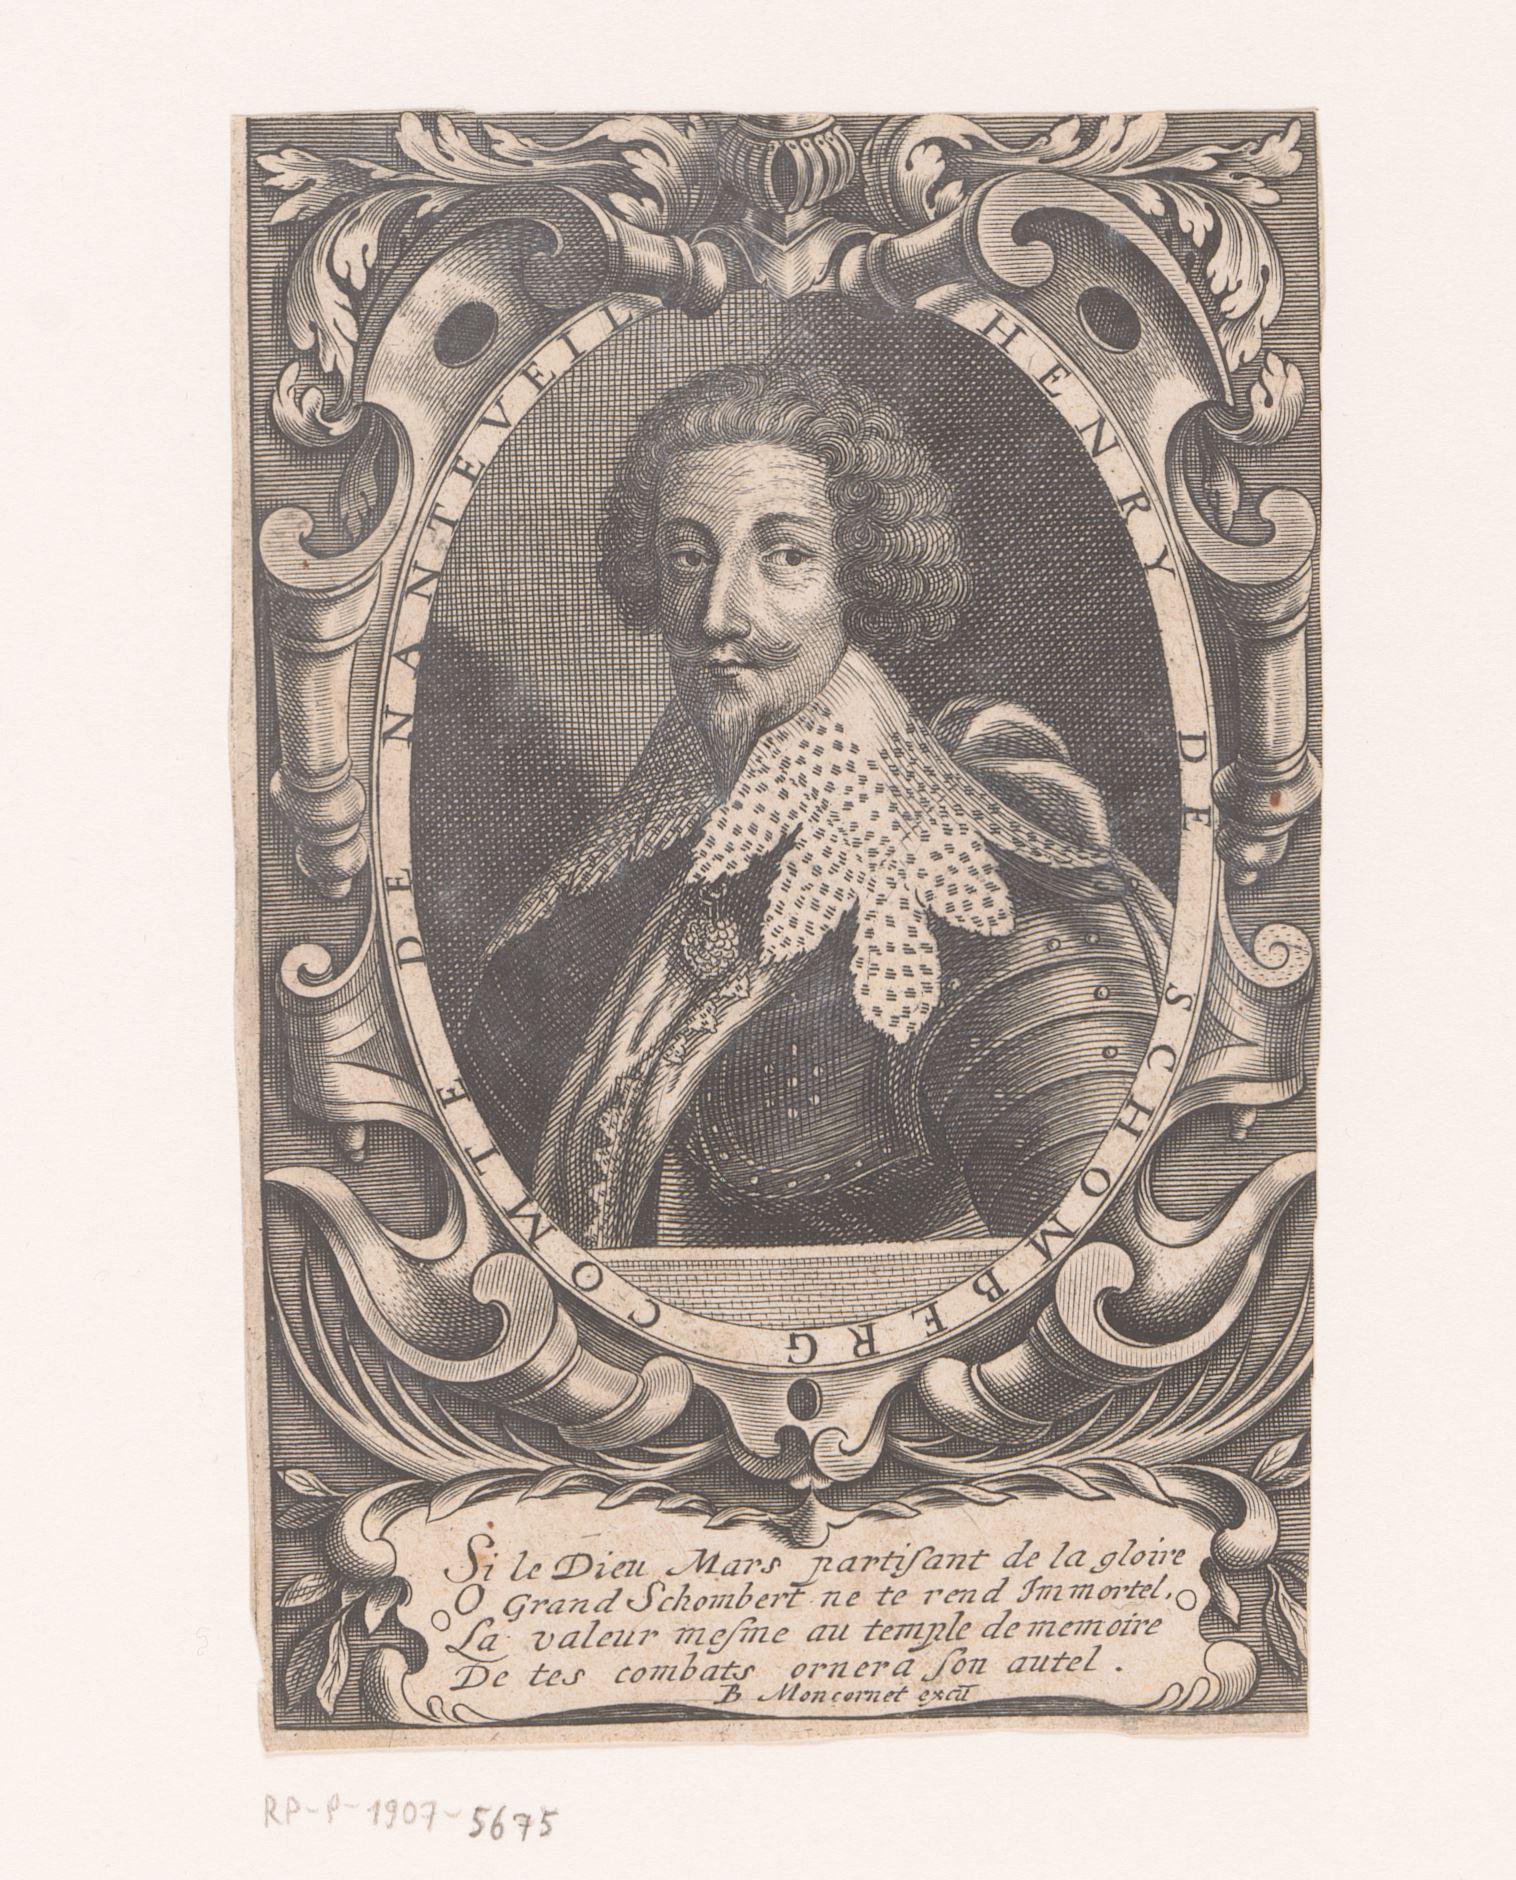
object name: print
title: Portret van Henri de Schomberg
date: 1615-1668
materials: paper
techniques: engraving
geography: paris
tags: commander-in-chief, general, marshal, historical persons, nobility and patriciate; chivalry, knighthood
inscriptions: collector's mark: Lugt 2228